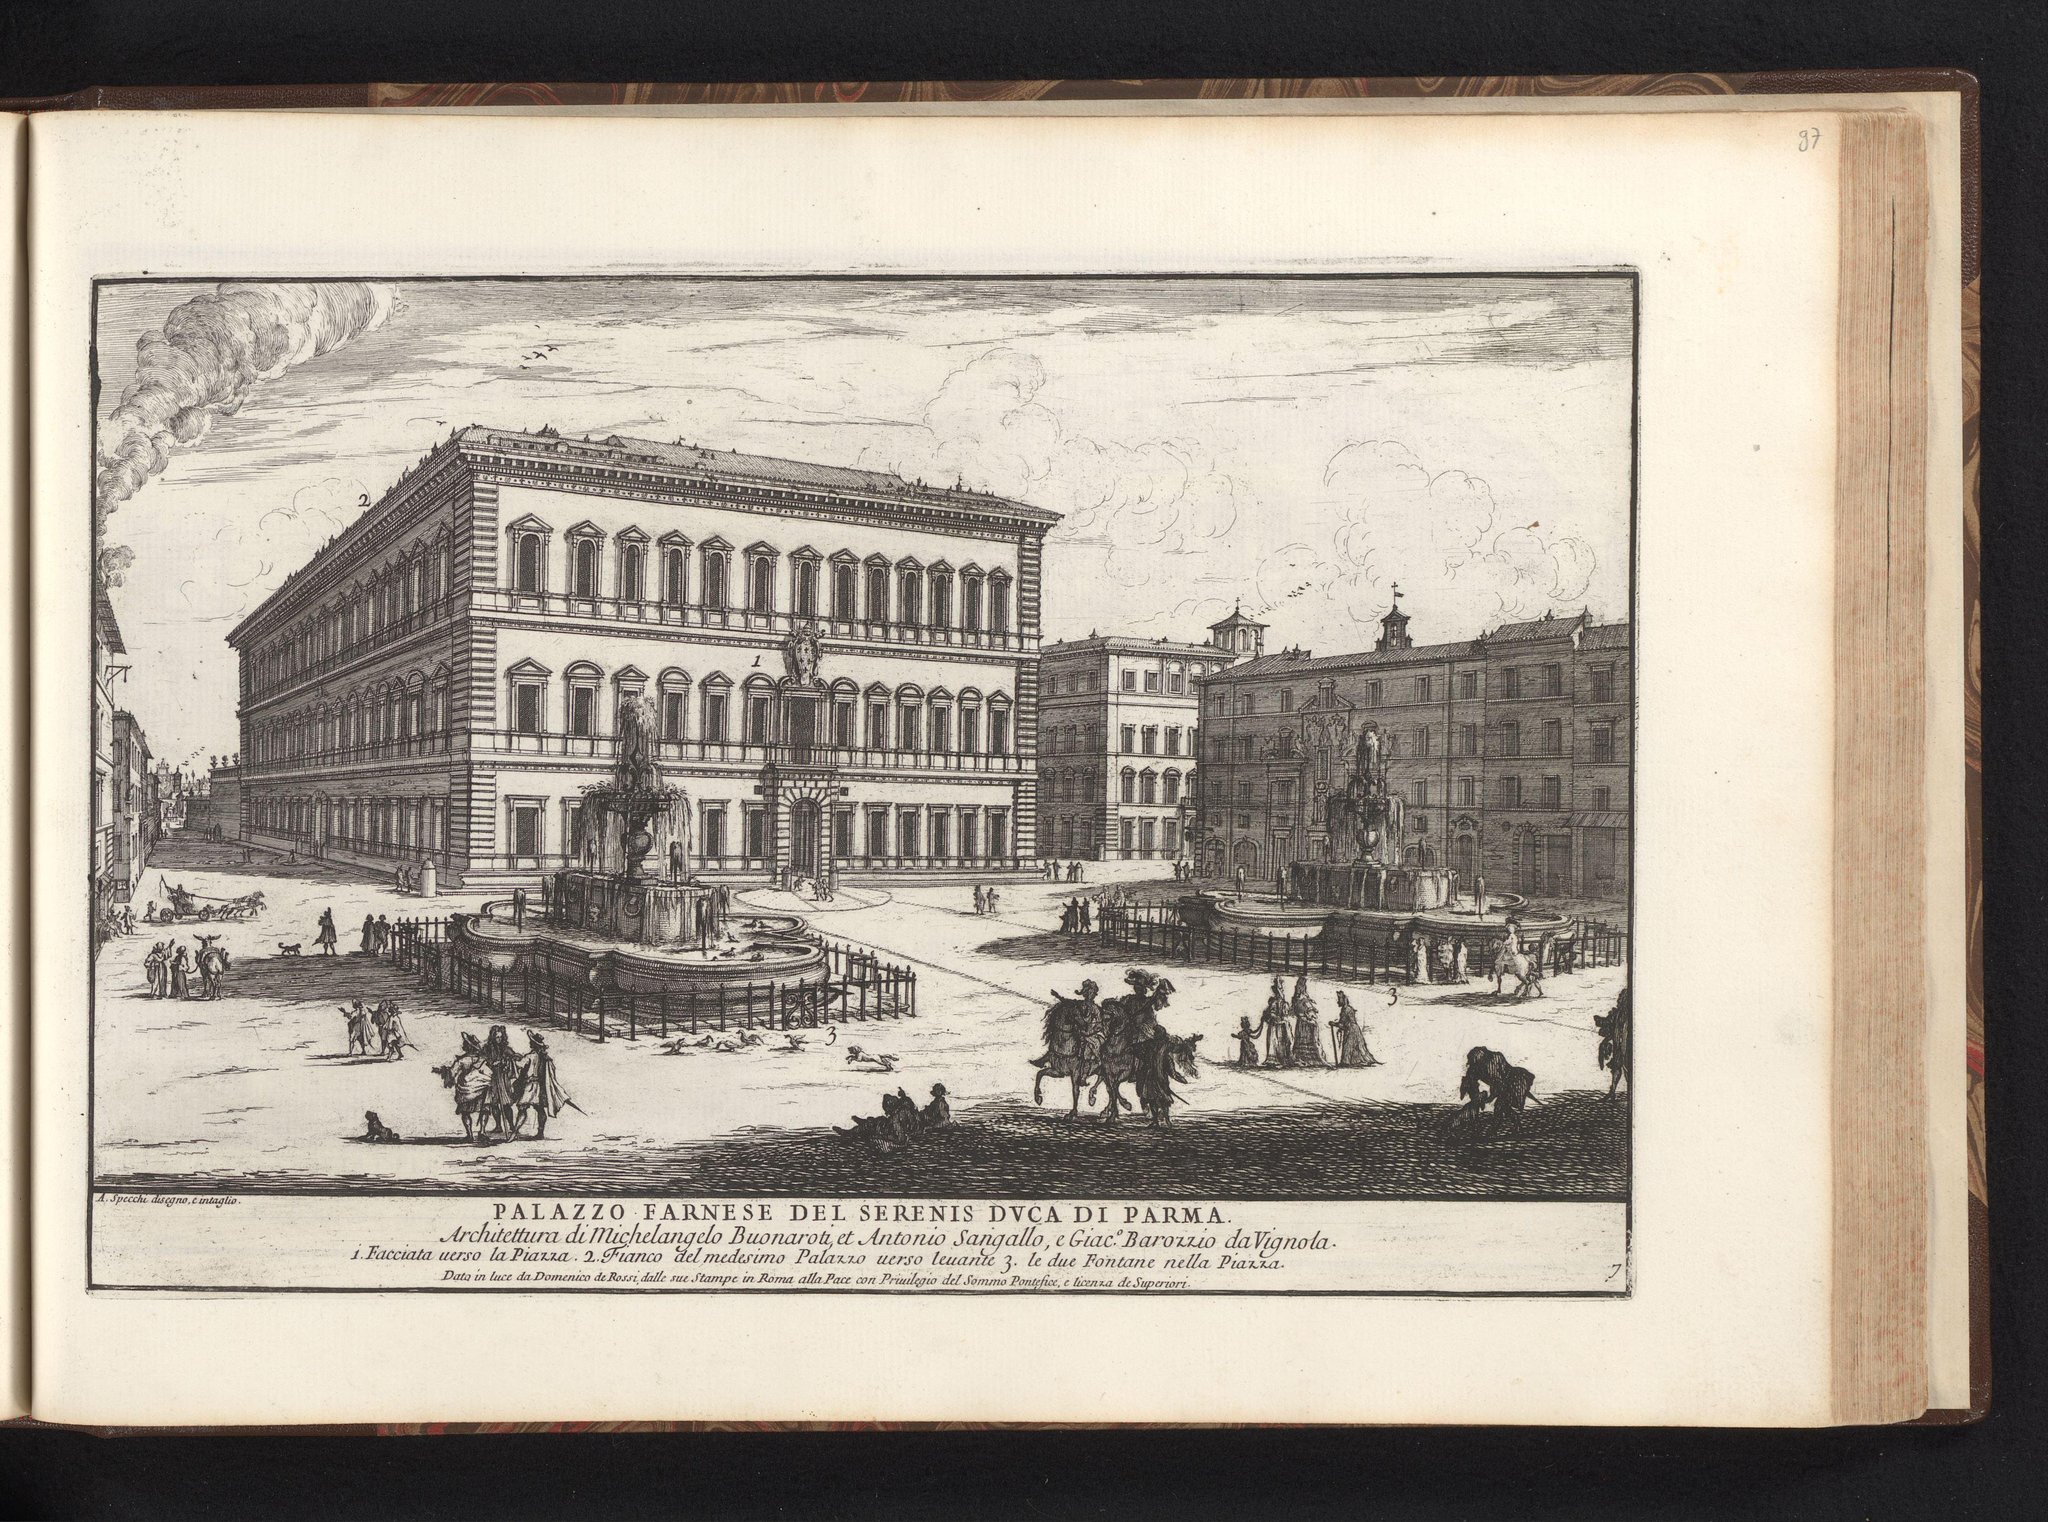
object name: album leaf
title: Moderne gebouwen te Rome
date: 1699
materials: paper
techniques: etching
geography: rome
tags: palace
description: Deze prent maakt deel uit van een reeks van 52 prenten met voorstellingen van paleizen in Rome. Samen met vier andere reeksen vormt het de grote reeks: 'Il nuovo teatro di Roma moderna'.